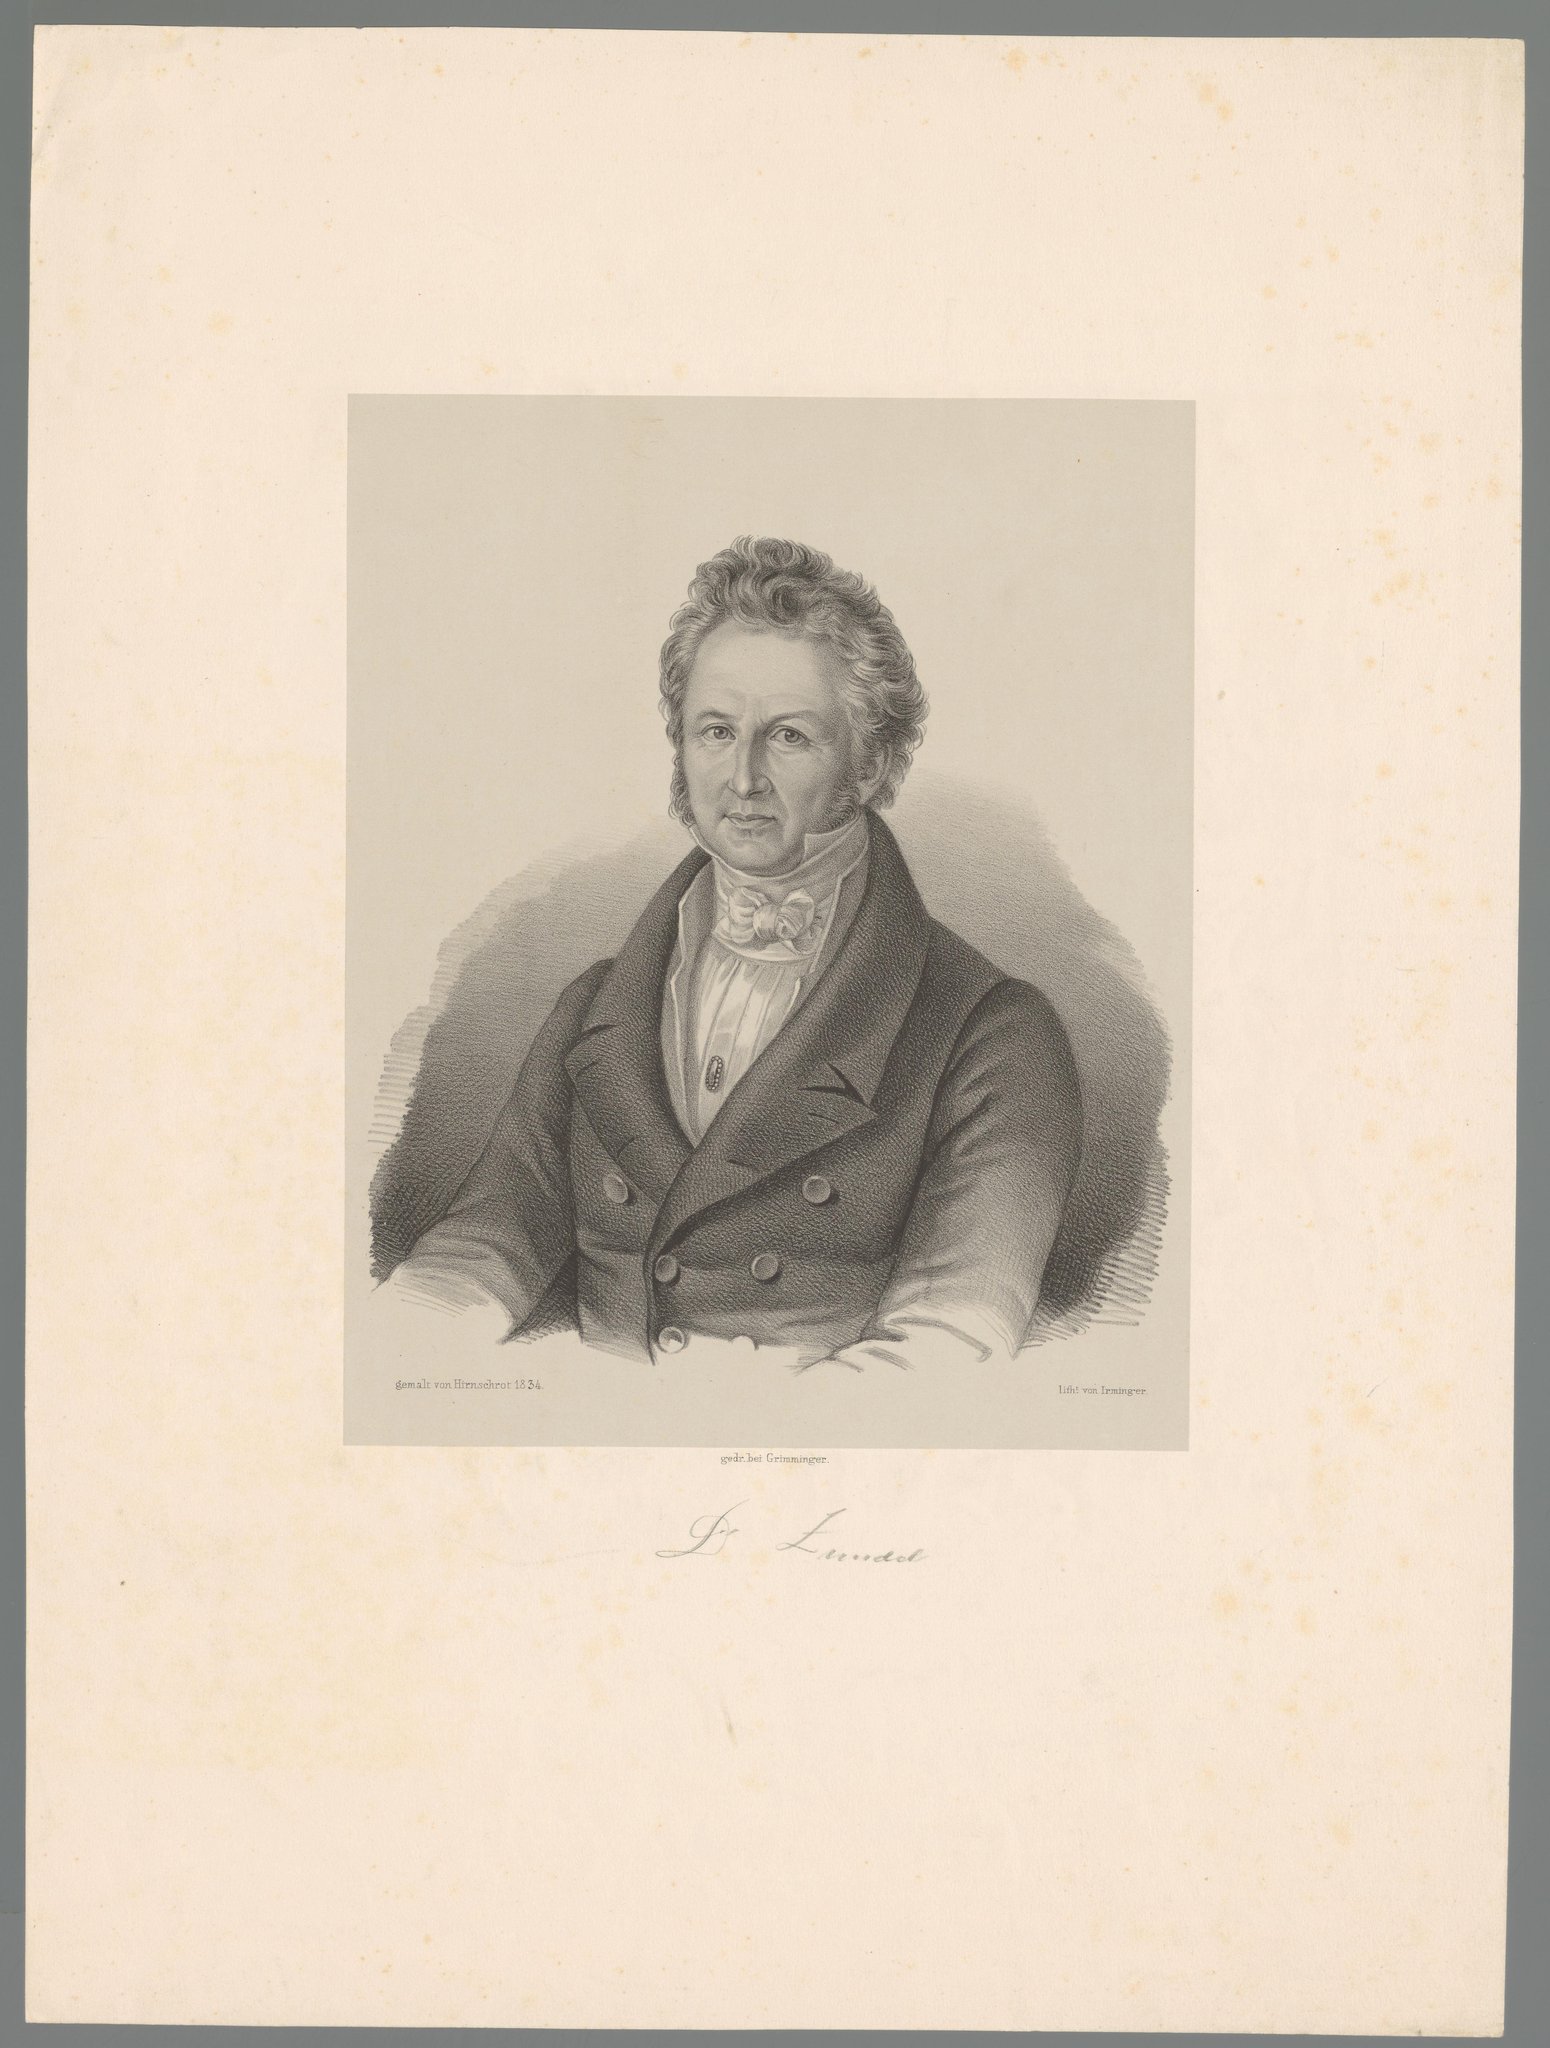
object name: print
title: Portret van David Zundel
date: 1834-1863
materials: paper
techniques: lithograph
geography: zurich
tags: adult man, historical persons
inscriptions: collector's mark: Lugt 2228